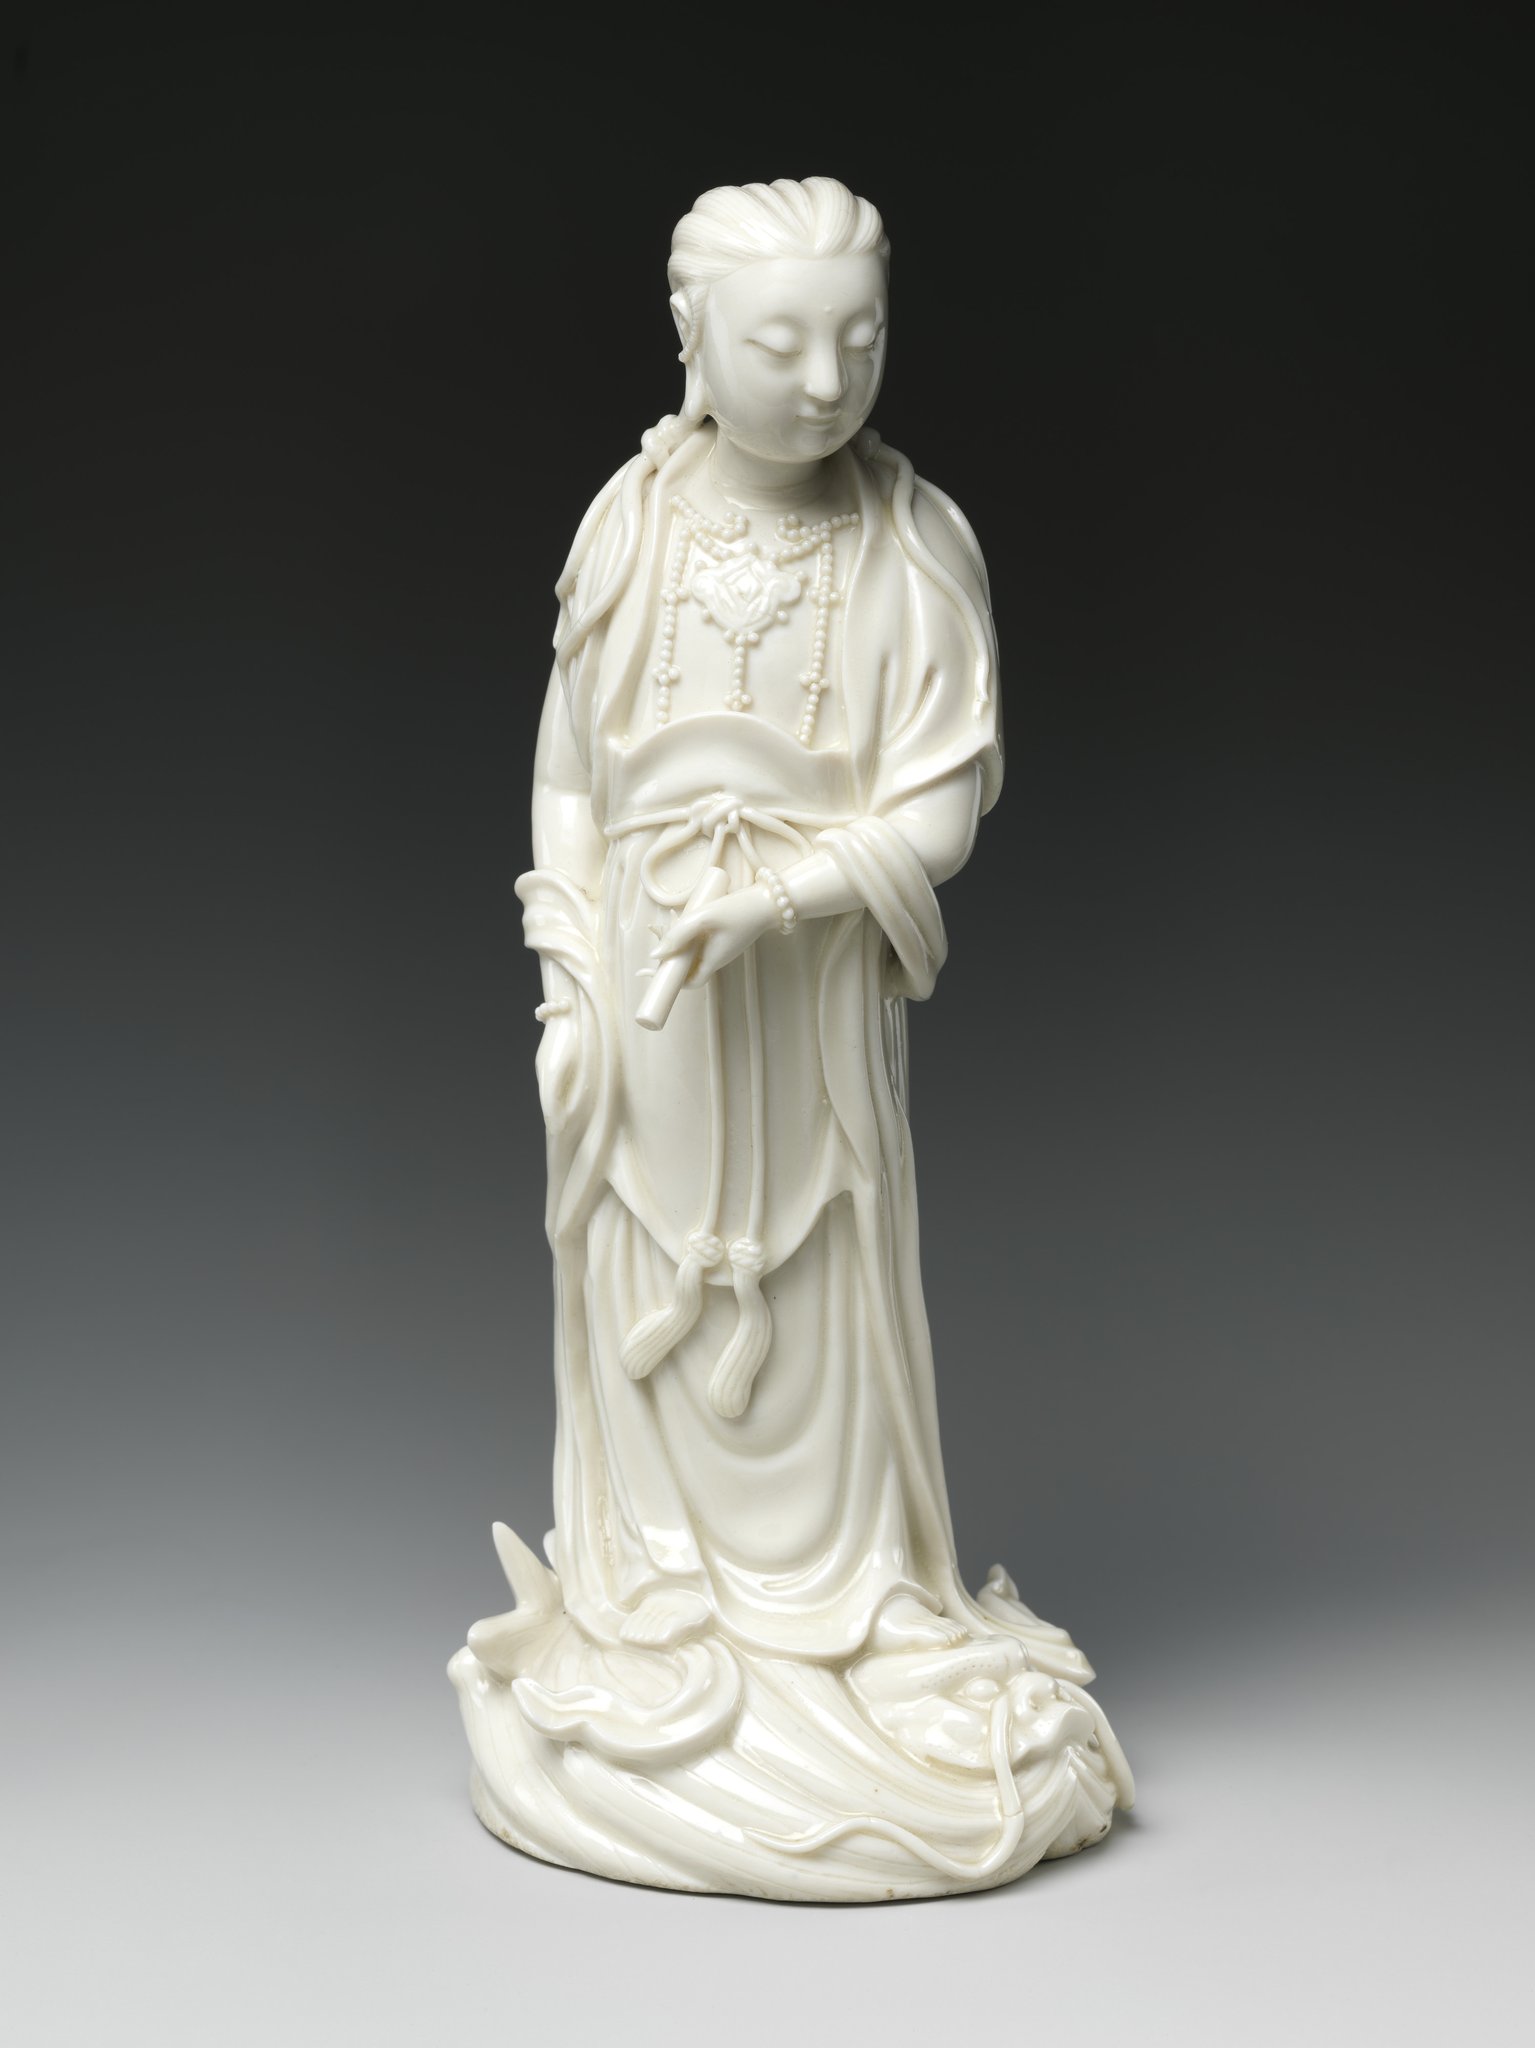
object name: figure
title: Bodhisattva Guanyin standing on a dragonfish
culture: chinese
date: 1801-1900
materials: glaze, ivory, porcelain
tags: buddhism,bodhisattvas